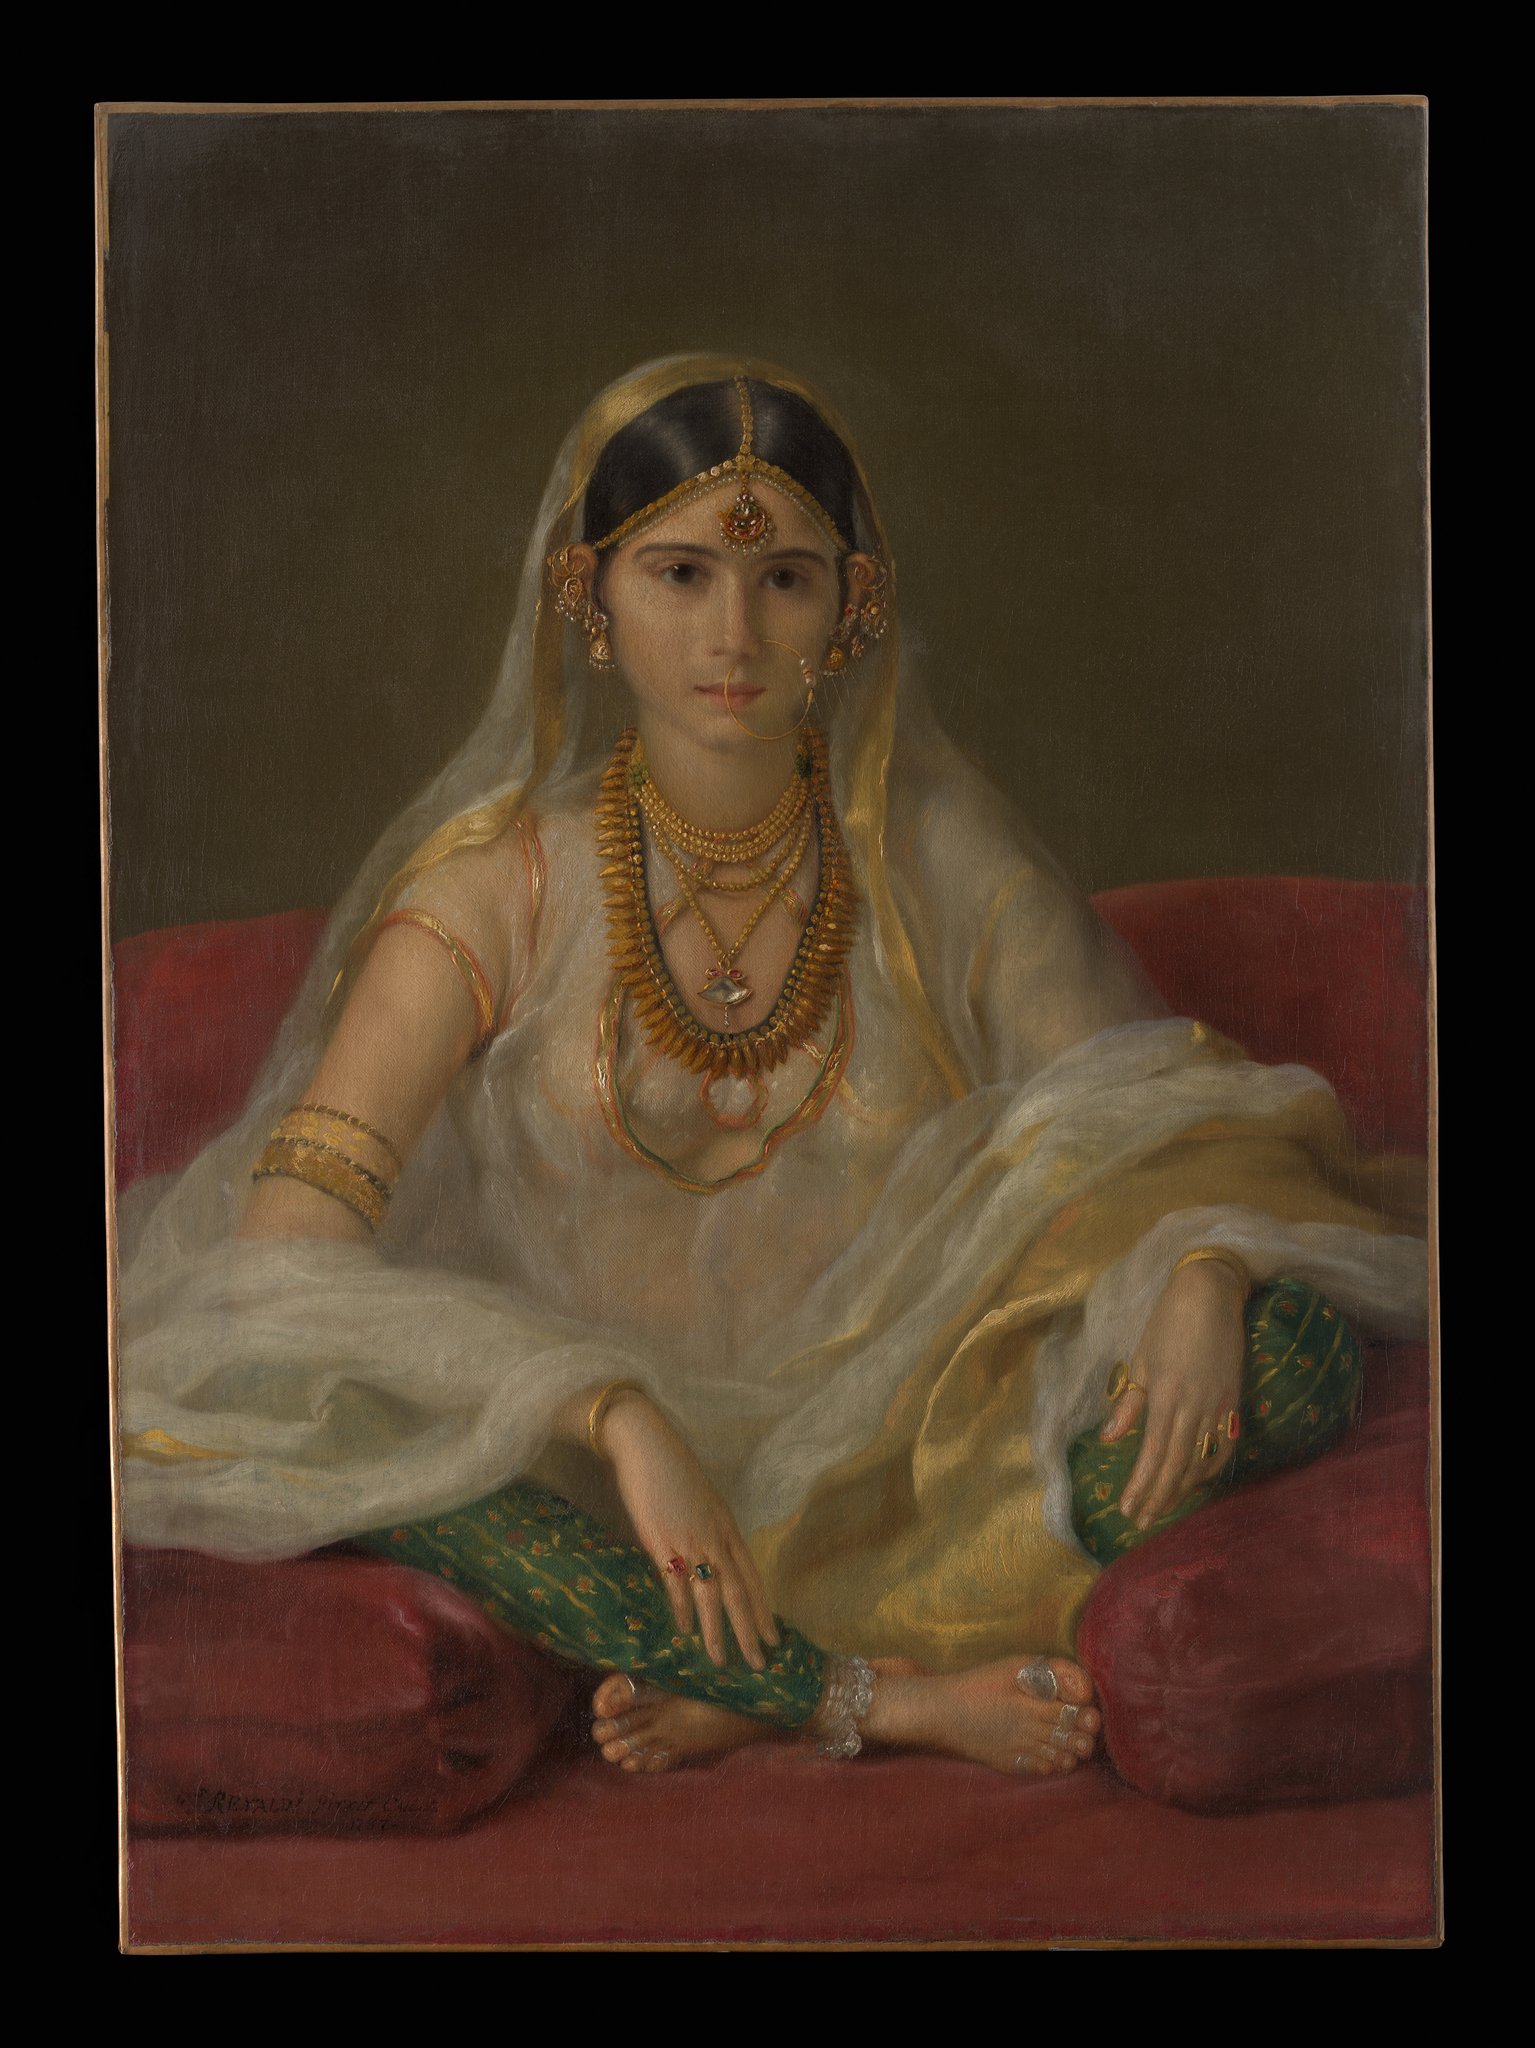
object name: painting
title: Portrait of a Mughal Woman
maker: francesco renaldi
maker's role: artist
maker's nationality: british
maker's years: 1755-1800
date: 1787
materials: canvas, oil